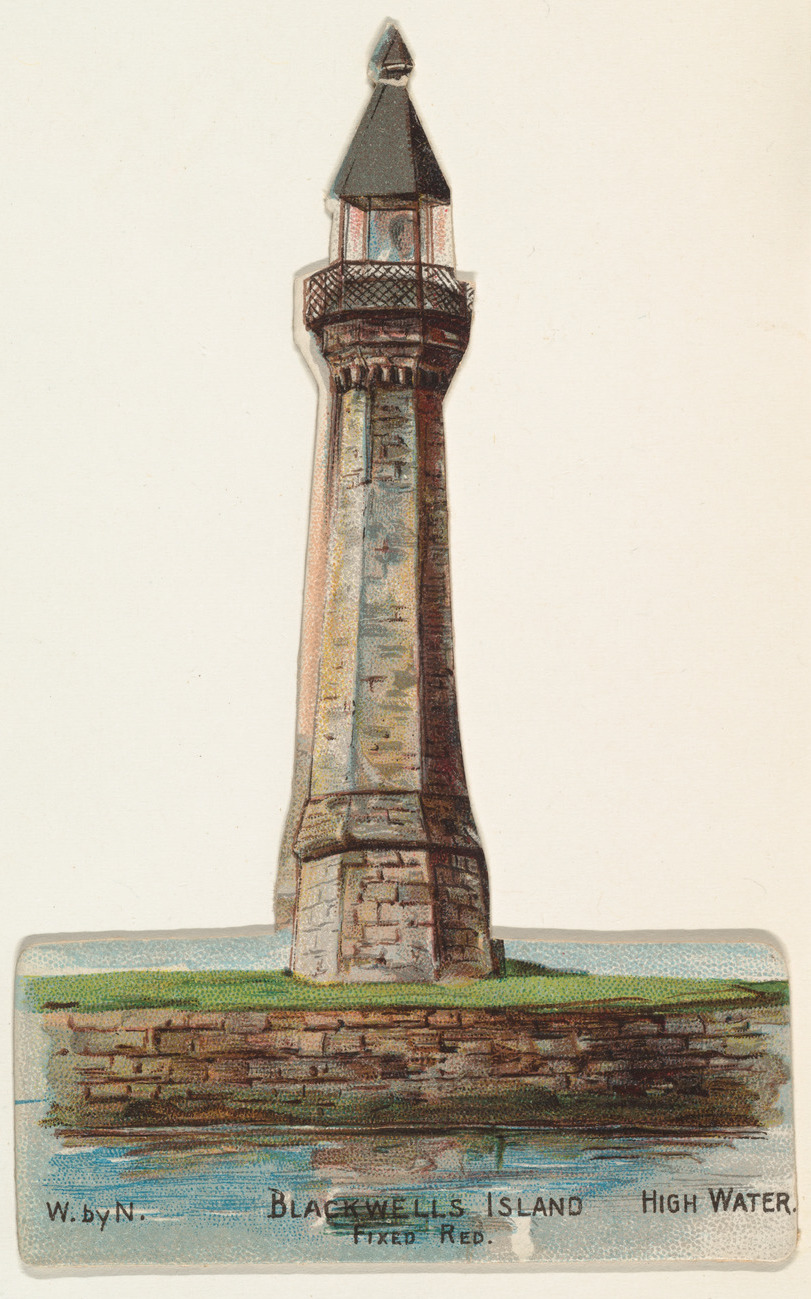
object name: print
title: Blackwells Island, from the Lighthouses series (N119) issued by Duke Sons & Co. to promote Honest Long Cut Tobacco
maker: w. duke, sons & co.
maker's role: publisher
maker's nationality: american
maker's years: 1870-1920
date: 1889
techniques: color lithograph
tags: lighthouses